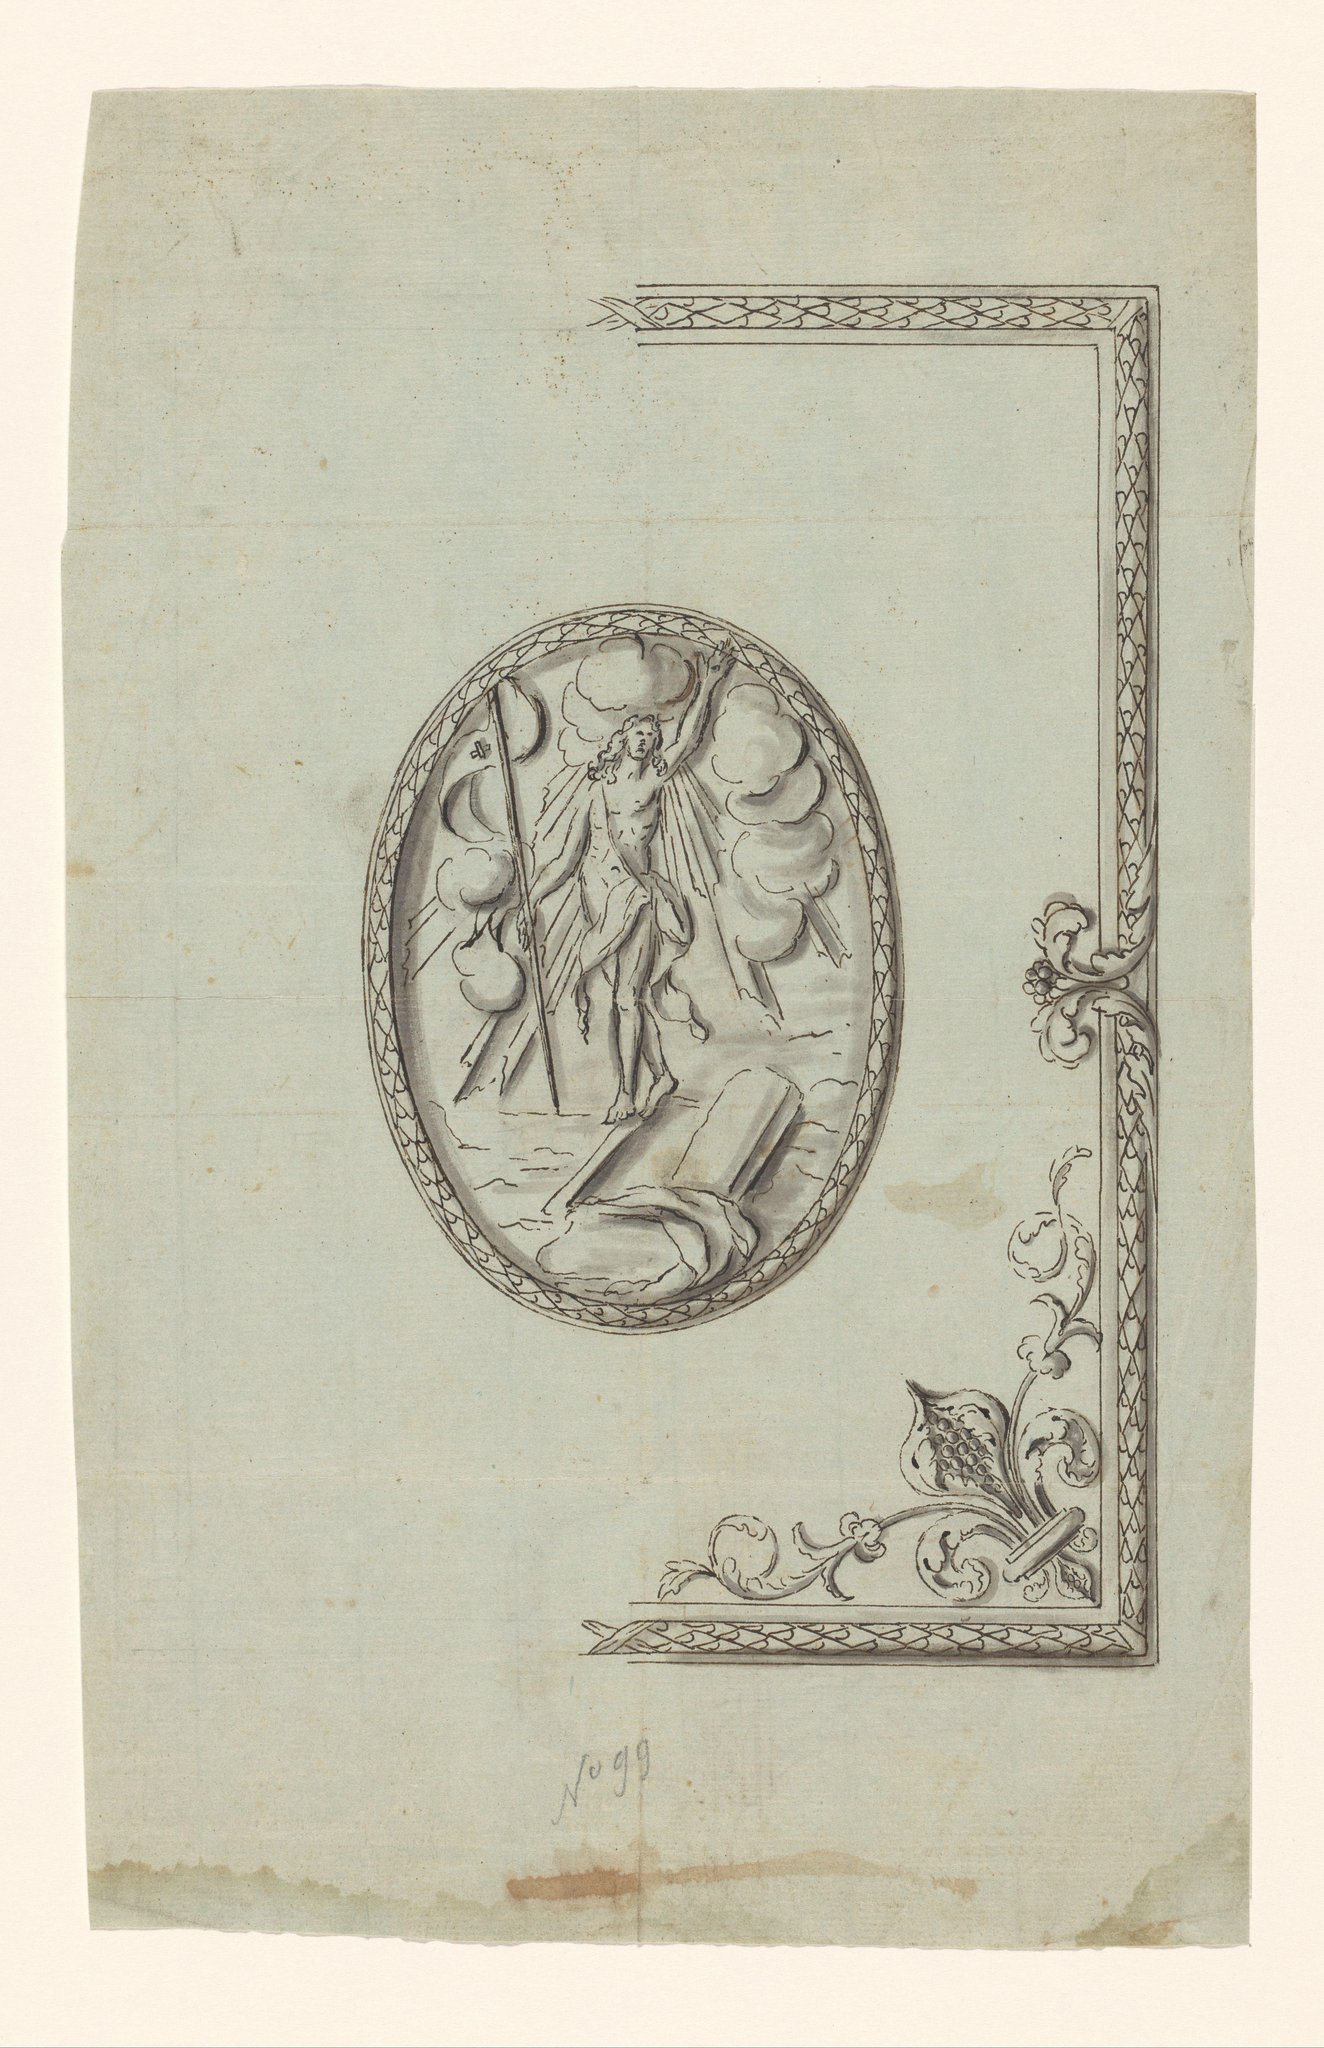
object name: design drawing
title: Ontwerp voor het beslag van een boekband, met een medaillon met de herrijzenis van Christus en een lelie in de hoek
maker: Anonymous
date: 1780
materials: graphite, ink, paper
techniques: brush, pen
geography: paris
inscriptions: number: ‘No 99’, watermark: ‘Lange, onleesbare tekst.’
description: Variant op de bovenste helft van 20. Hier is de voorstelling van de hemelvaart van Maria niet in een andere hand. Door spijker samengevoegd met RP-T-2019-356.